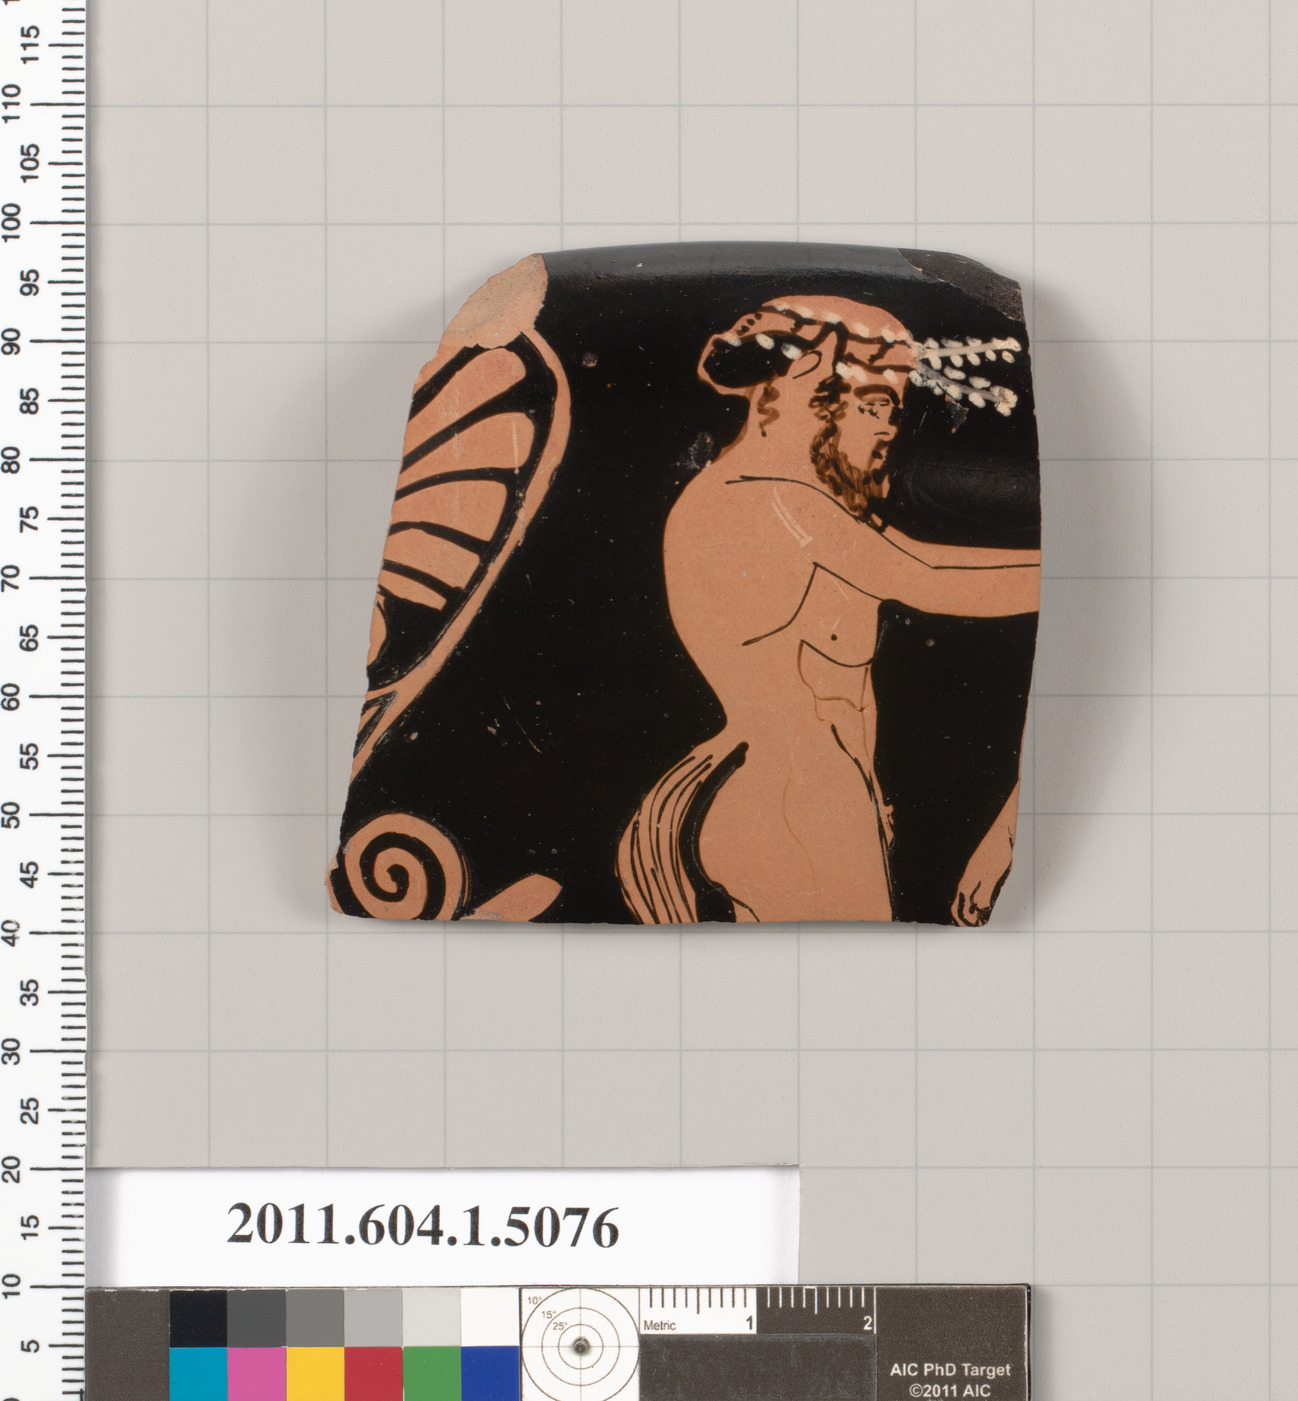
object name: kylix fragment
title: Terracotta rim fragment of a kylix (drinking cup)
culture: greek, attic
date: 467-435 BCE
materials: terracotta